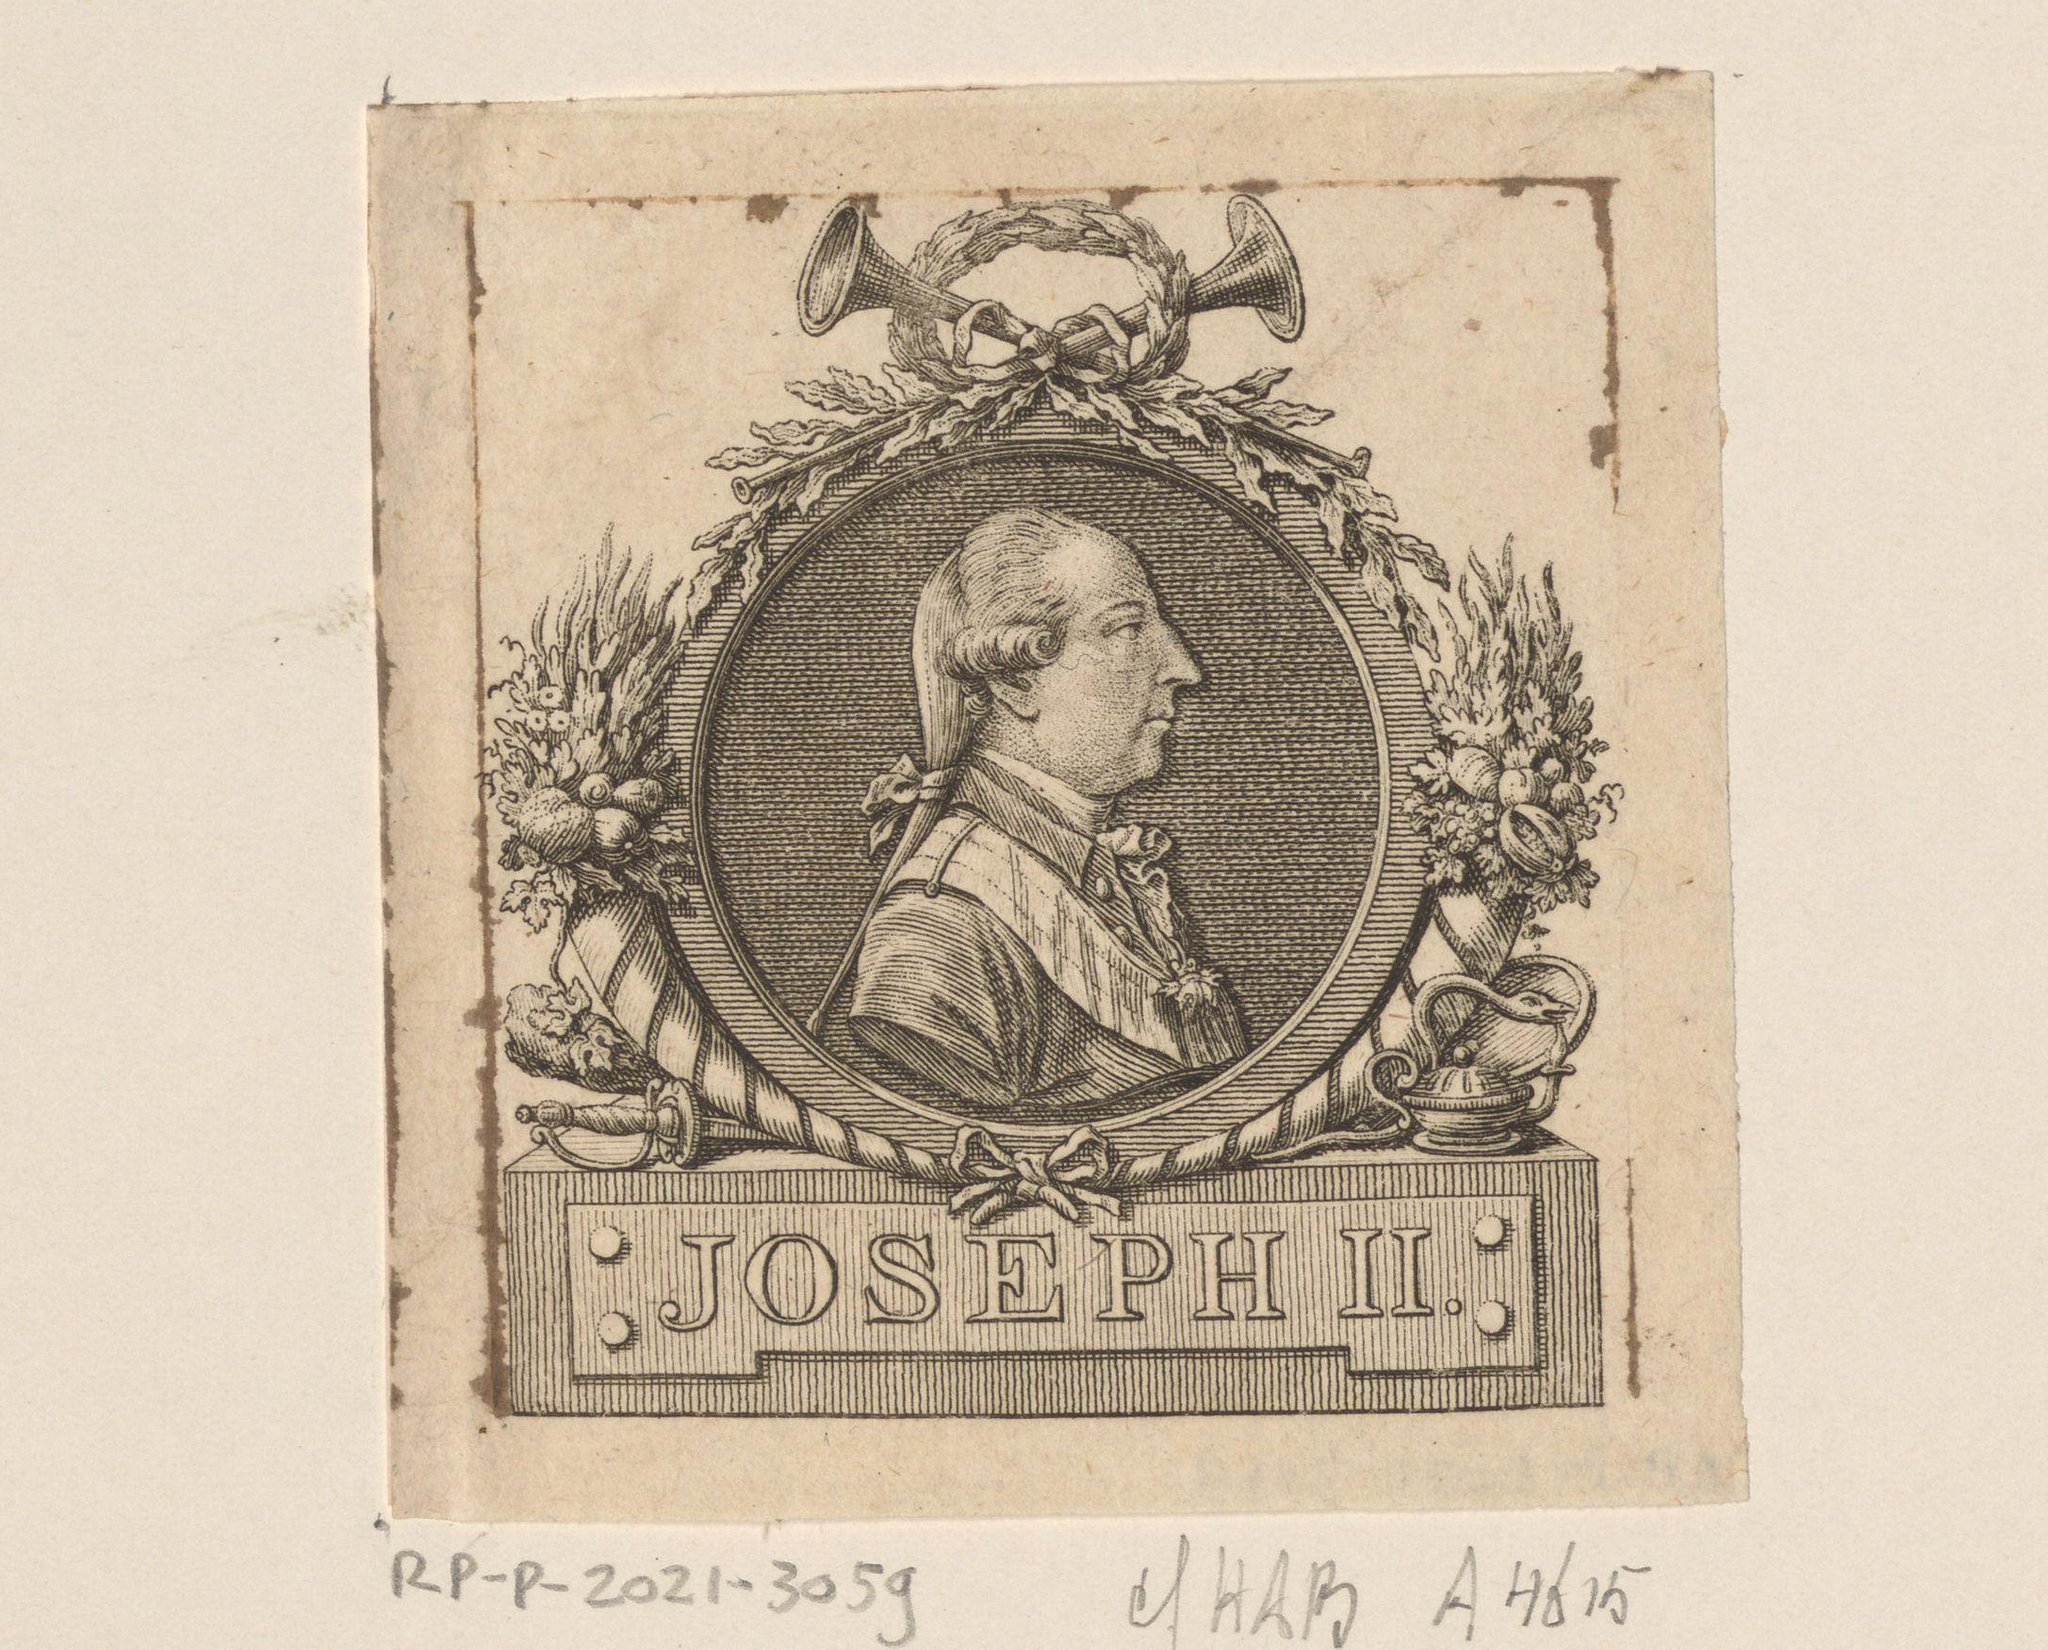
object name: print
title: Portret van Jozef II, Duits keizer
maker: Anonymous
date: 1765-1799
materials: paper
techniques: etching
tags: vienna, jozef ii (duits keizer), snakes, 'cornucopia', horn of plenty, historical persons, hacking and thrusting weapons: sword, emperor